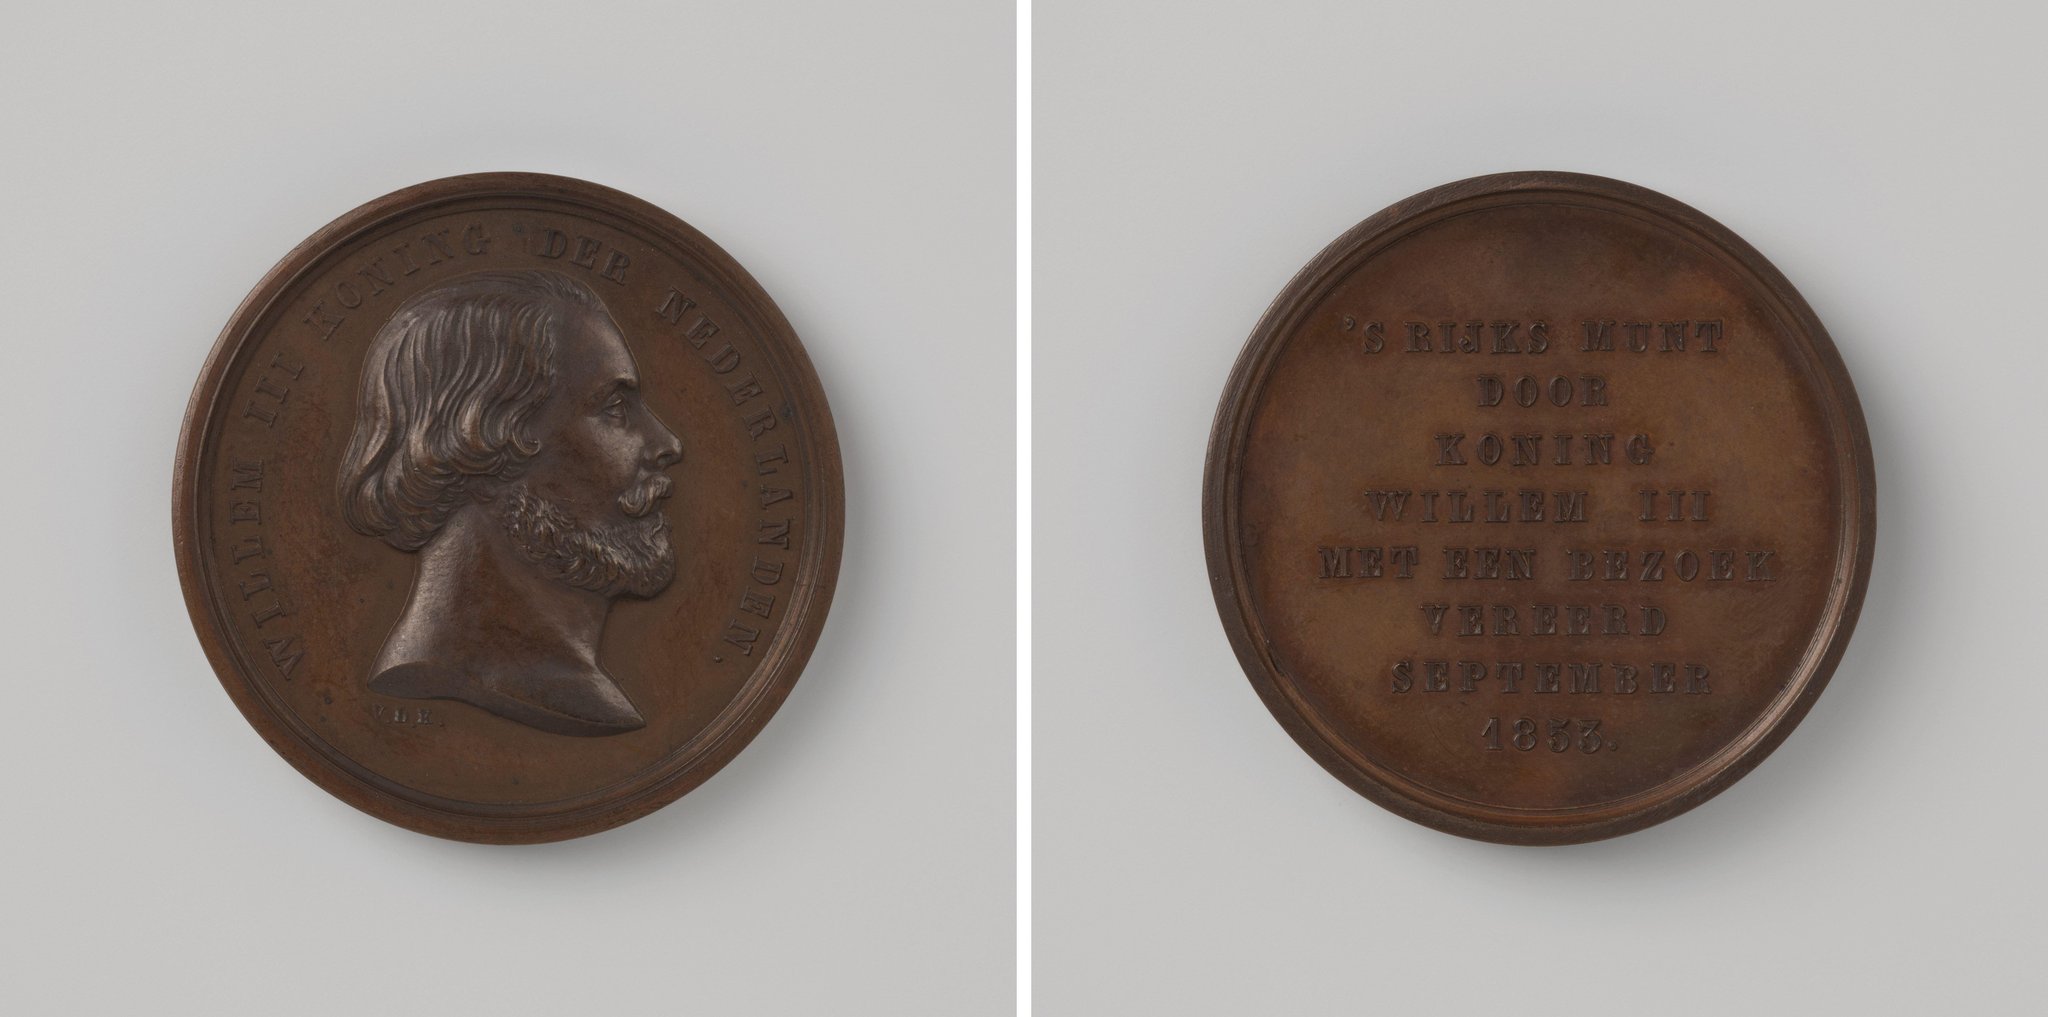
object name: history medal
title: Bezoek van Koning Willem III aan 's Rijks Munt te Utrecht 1853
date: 1853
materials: bronze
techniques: striking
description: Bronzen penning, op de voorzijde het portret van Willem III naar rechts met omschrift, op de keerzijde acht regels tekst.